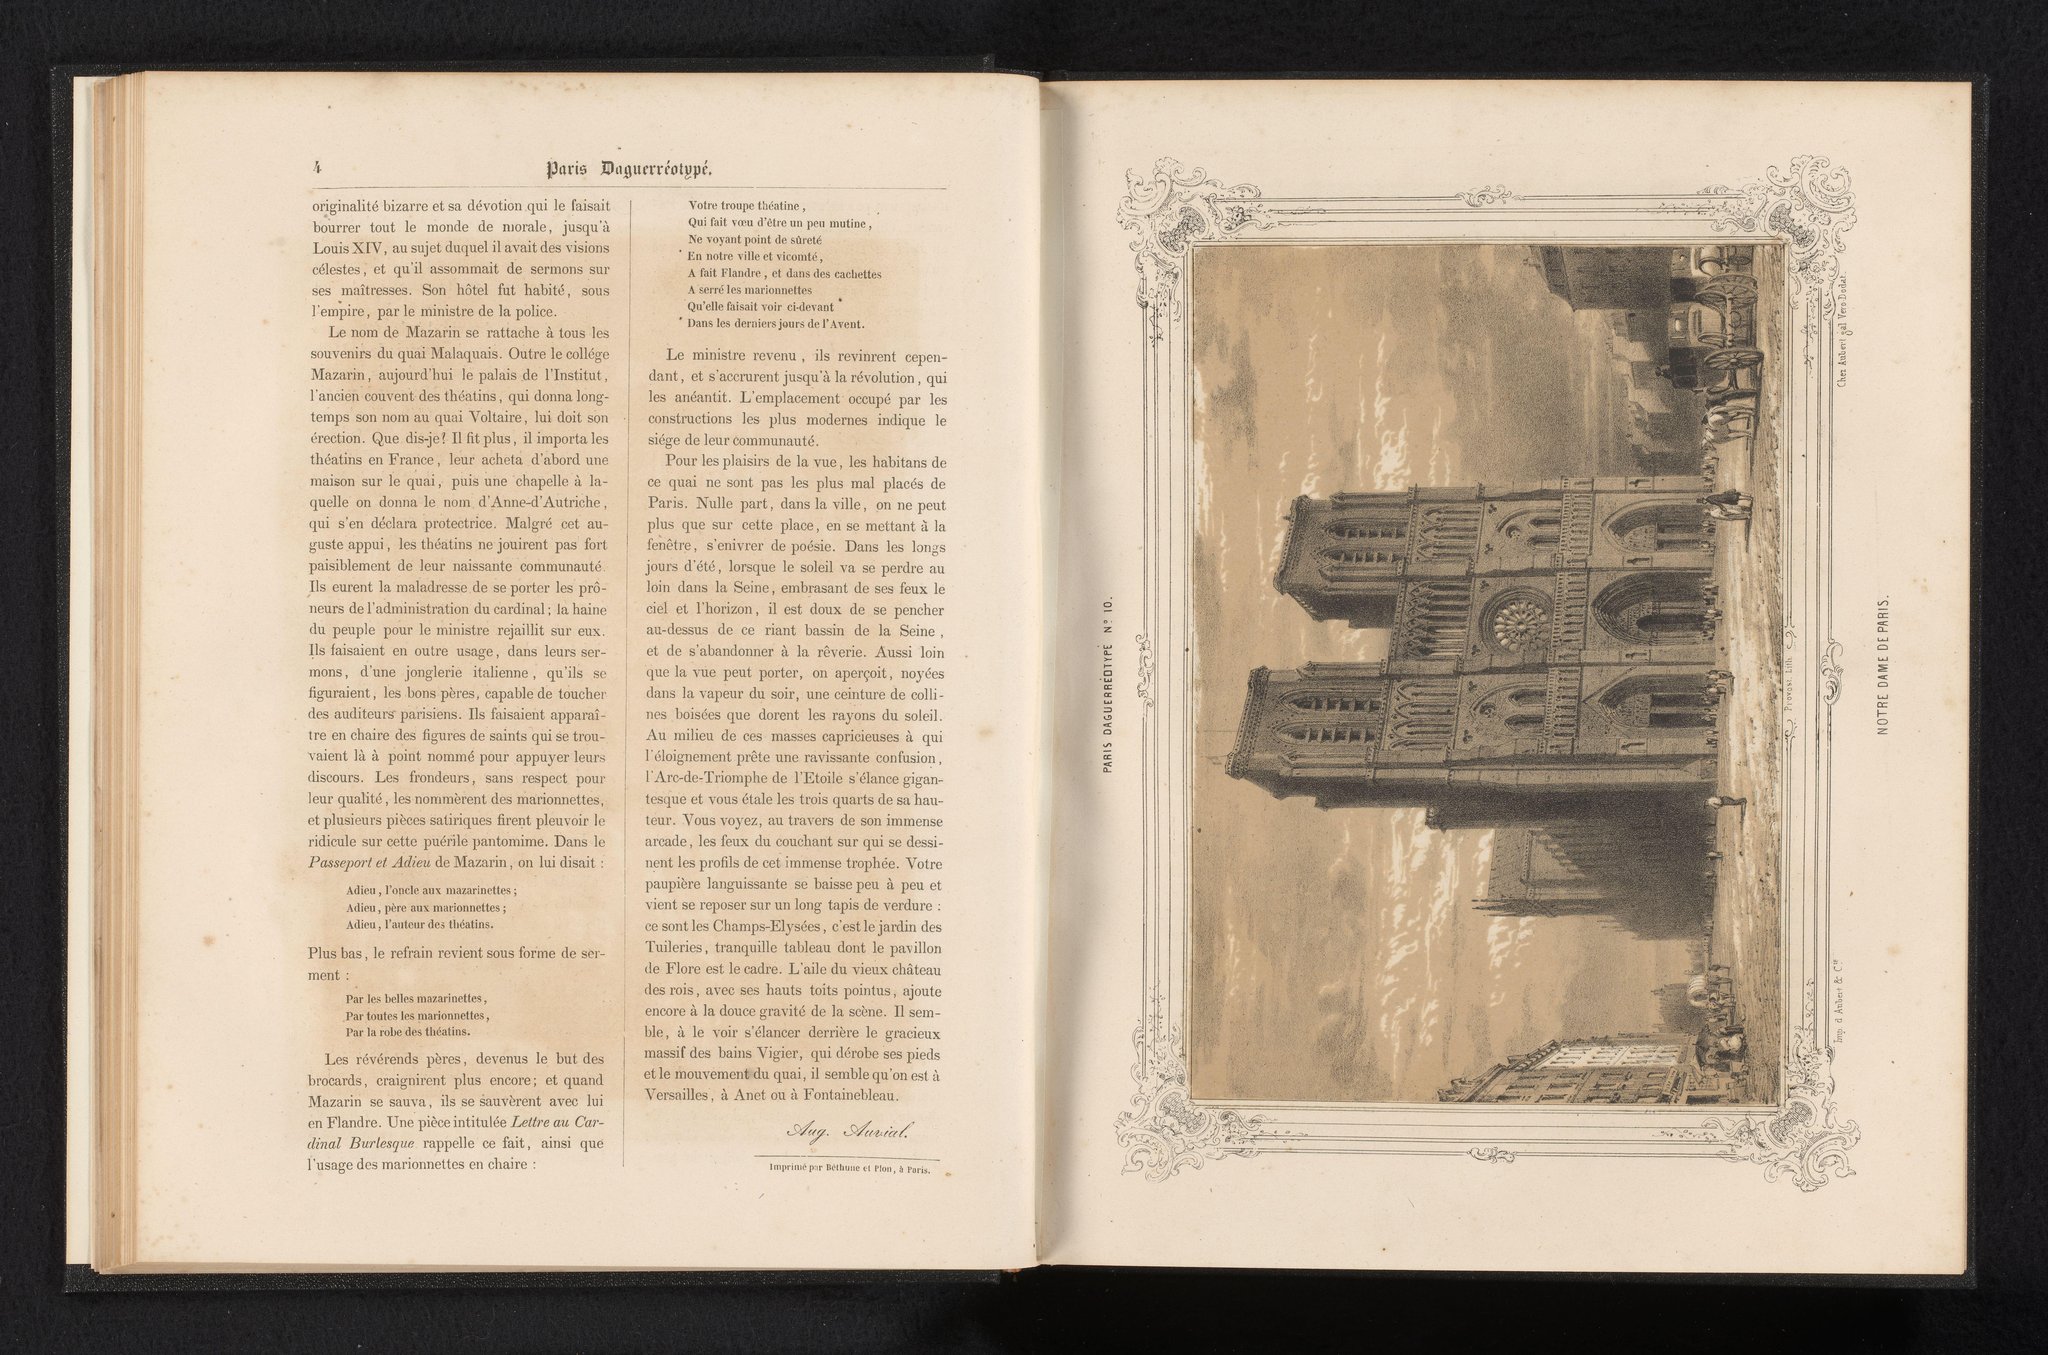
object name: page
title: Notre Dame de Paris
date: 1839-1840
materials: paper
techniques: tone lithography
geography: paris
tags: church (exterior)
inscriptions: inscription: ‘PARIS DAGUERRÉOTYPÉ No. 10.’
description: Prent op zevenendertigste ongenummerde pagina.